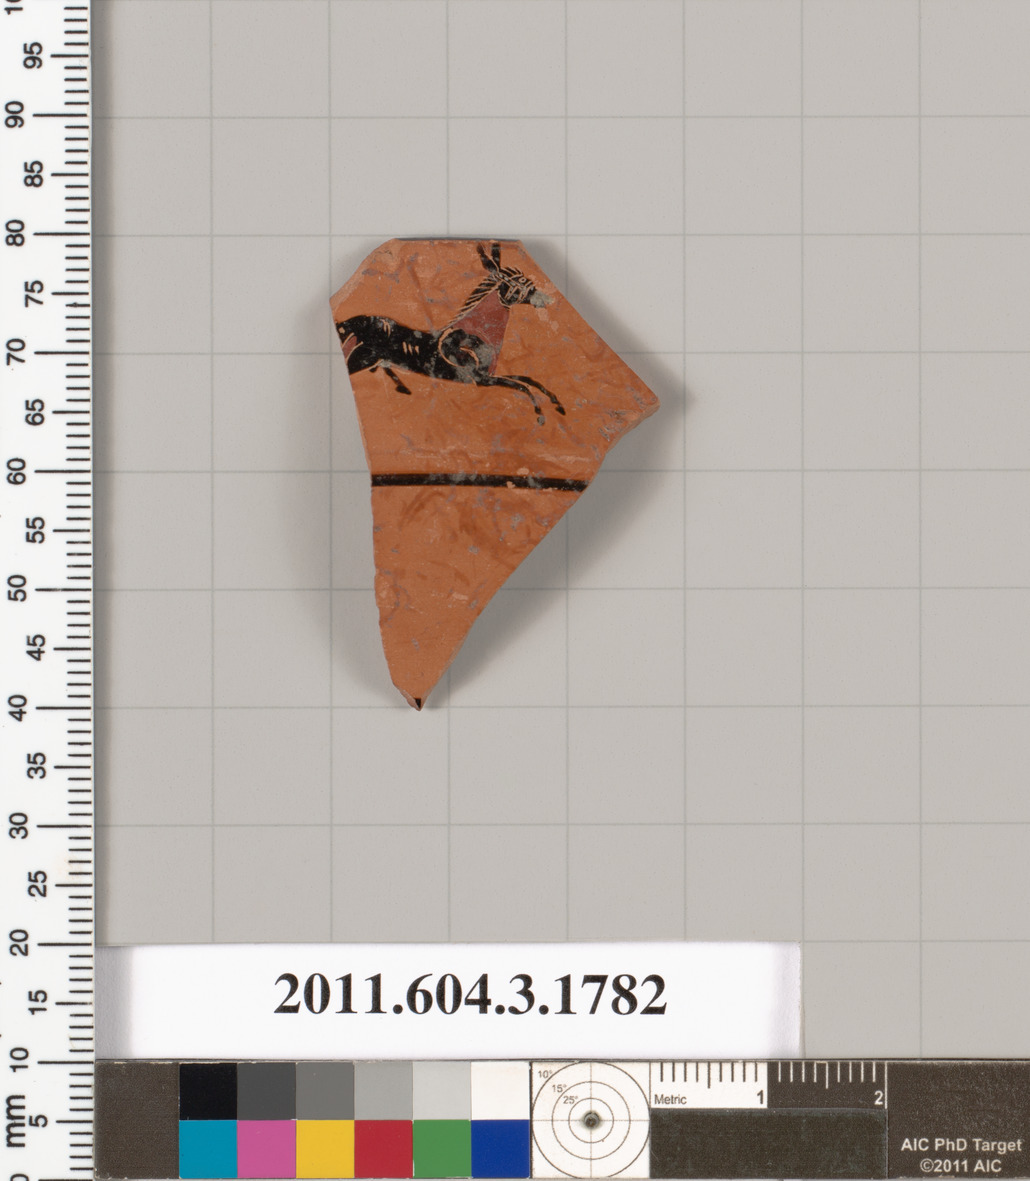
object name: kylix fragment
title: Terracotta rim fragment of a kylix: Lip cup (drinking cup)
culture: greek, attic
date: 560-550 BCE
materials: terracotta